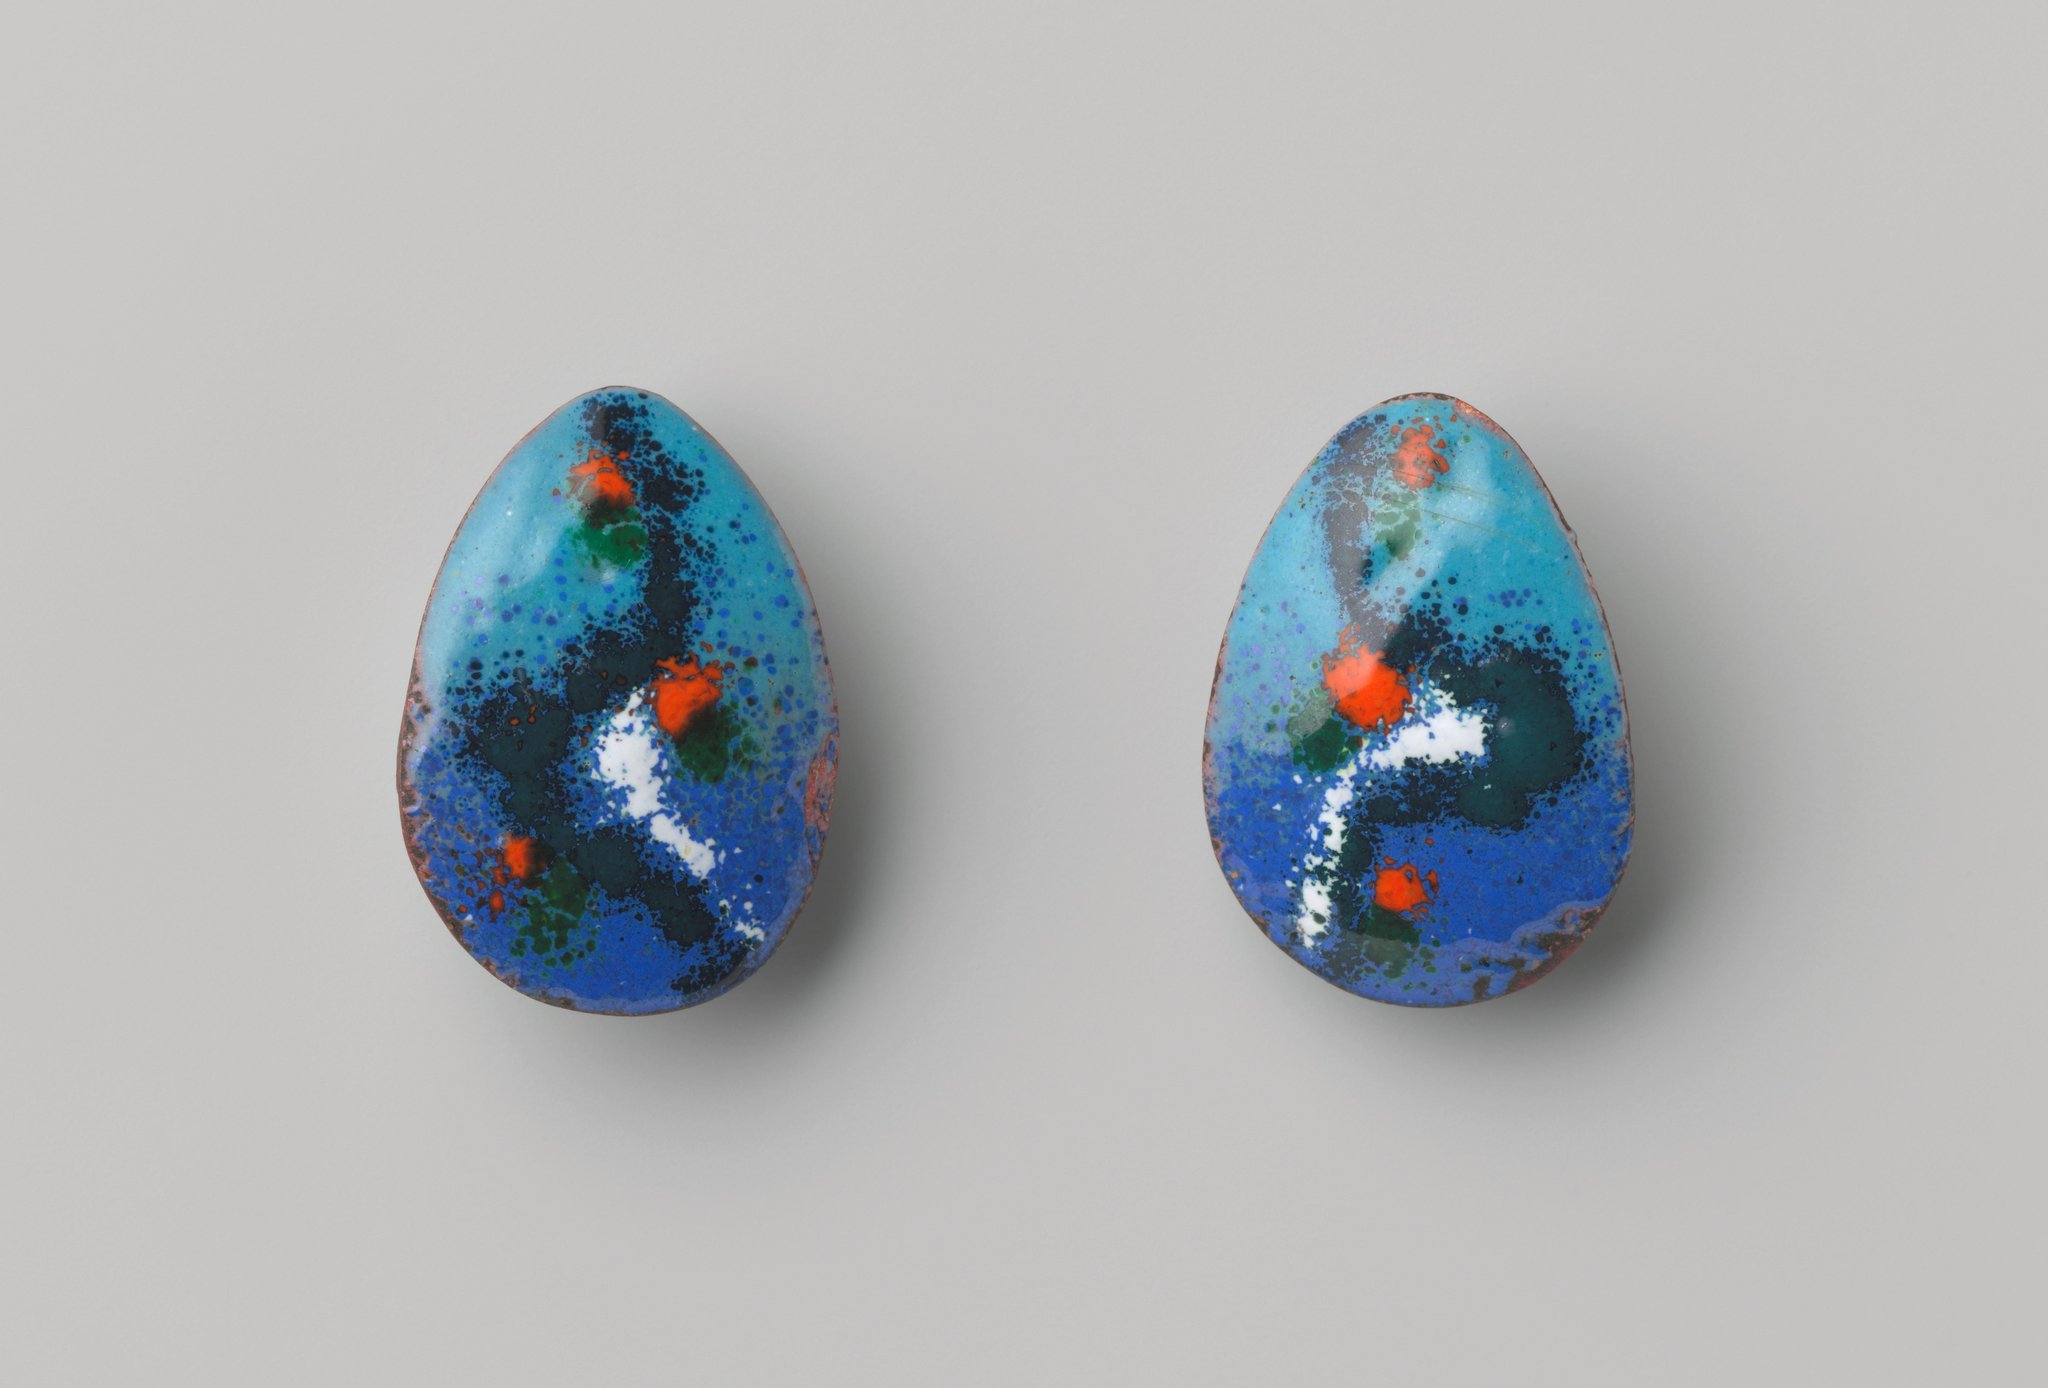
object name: earring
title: Eivormige oorclip van gevlekt email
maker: Anonymous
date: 1950-1960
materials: copper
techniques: enameling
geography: netherlands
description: Eivormige oorclip van gevlekt wit, rood en blauw email op koper.